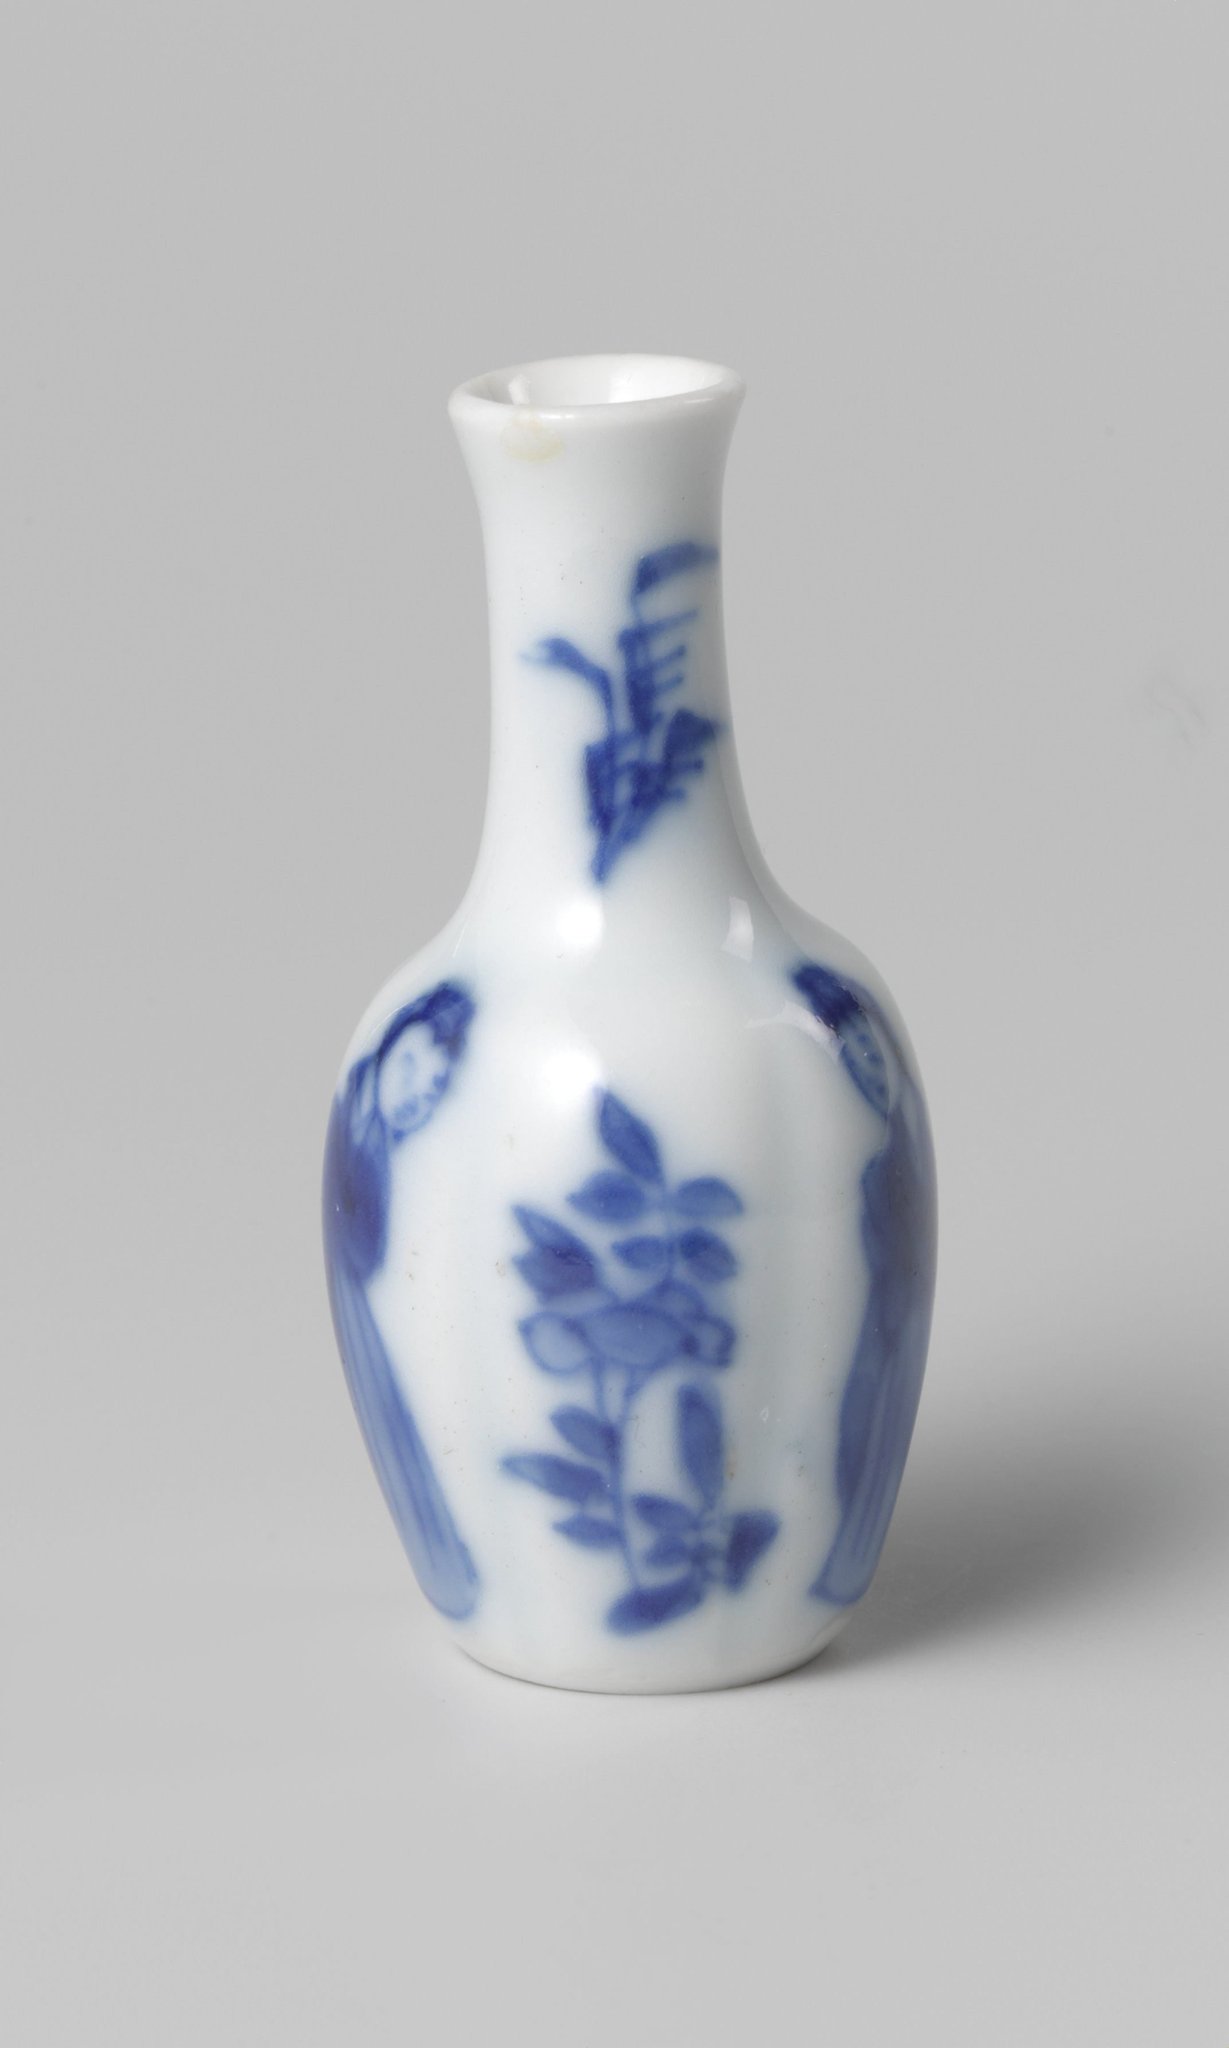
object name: vase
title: Miniature bottle vase with flowering plants and women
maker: Anonymous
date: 1675-1724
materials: cobalt, glaze, paint, porcelain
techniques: firing, turning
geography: china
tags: chinese, ornament derived from plant forms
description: Miniatuur zeslobbige, flesvormige vaas van porselein, beschilderd in onderglazuur blauw. Op de wand zesmaal afwisselend een bloeiende plant en een vrouw (lange lijs). Blauw-wit.